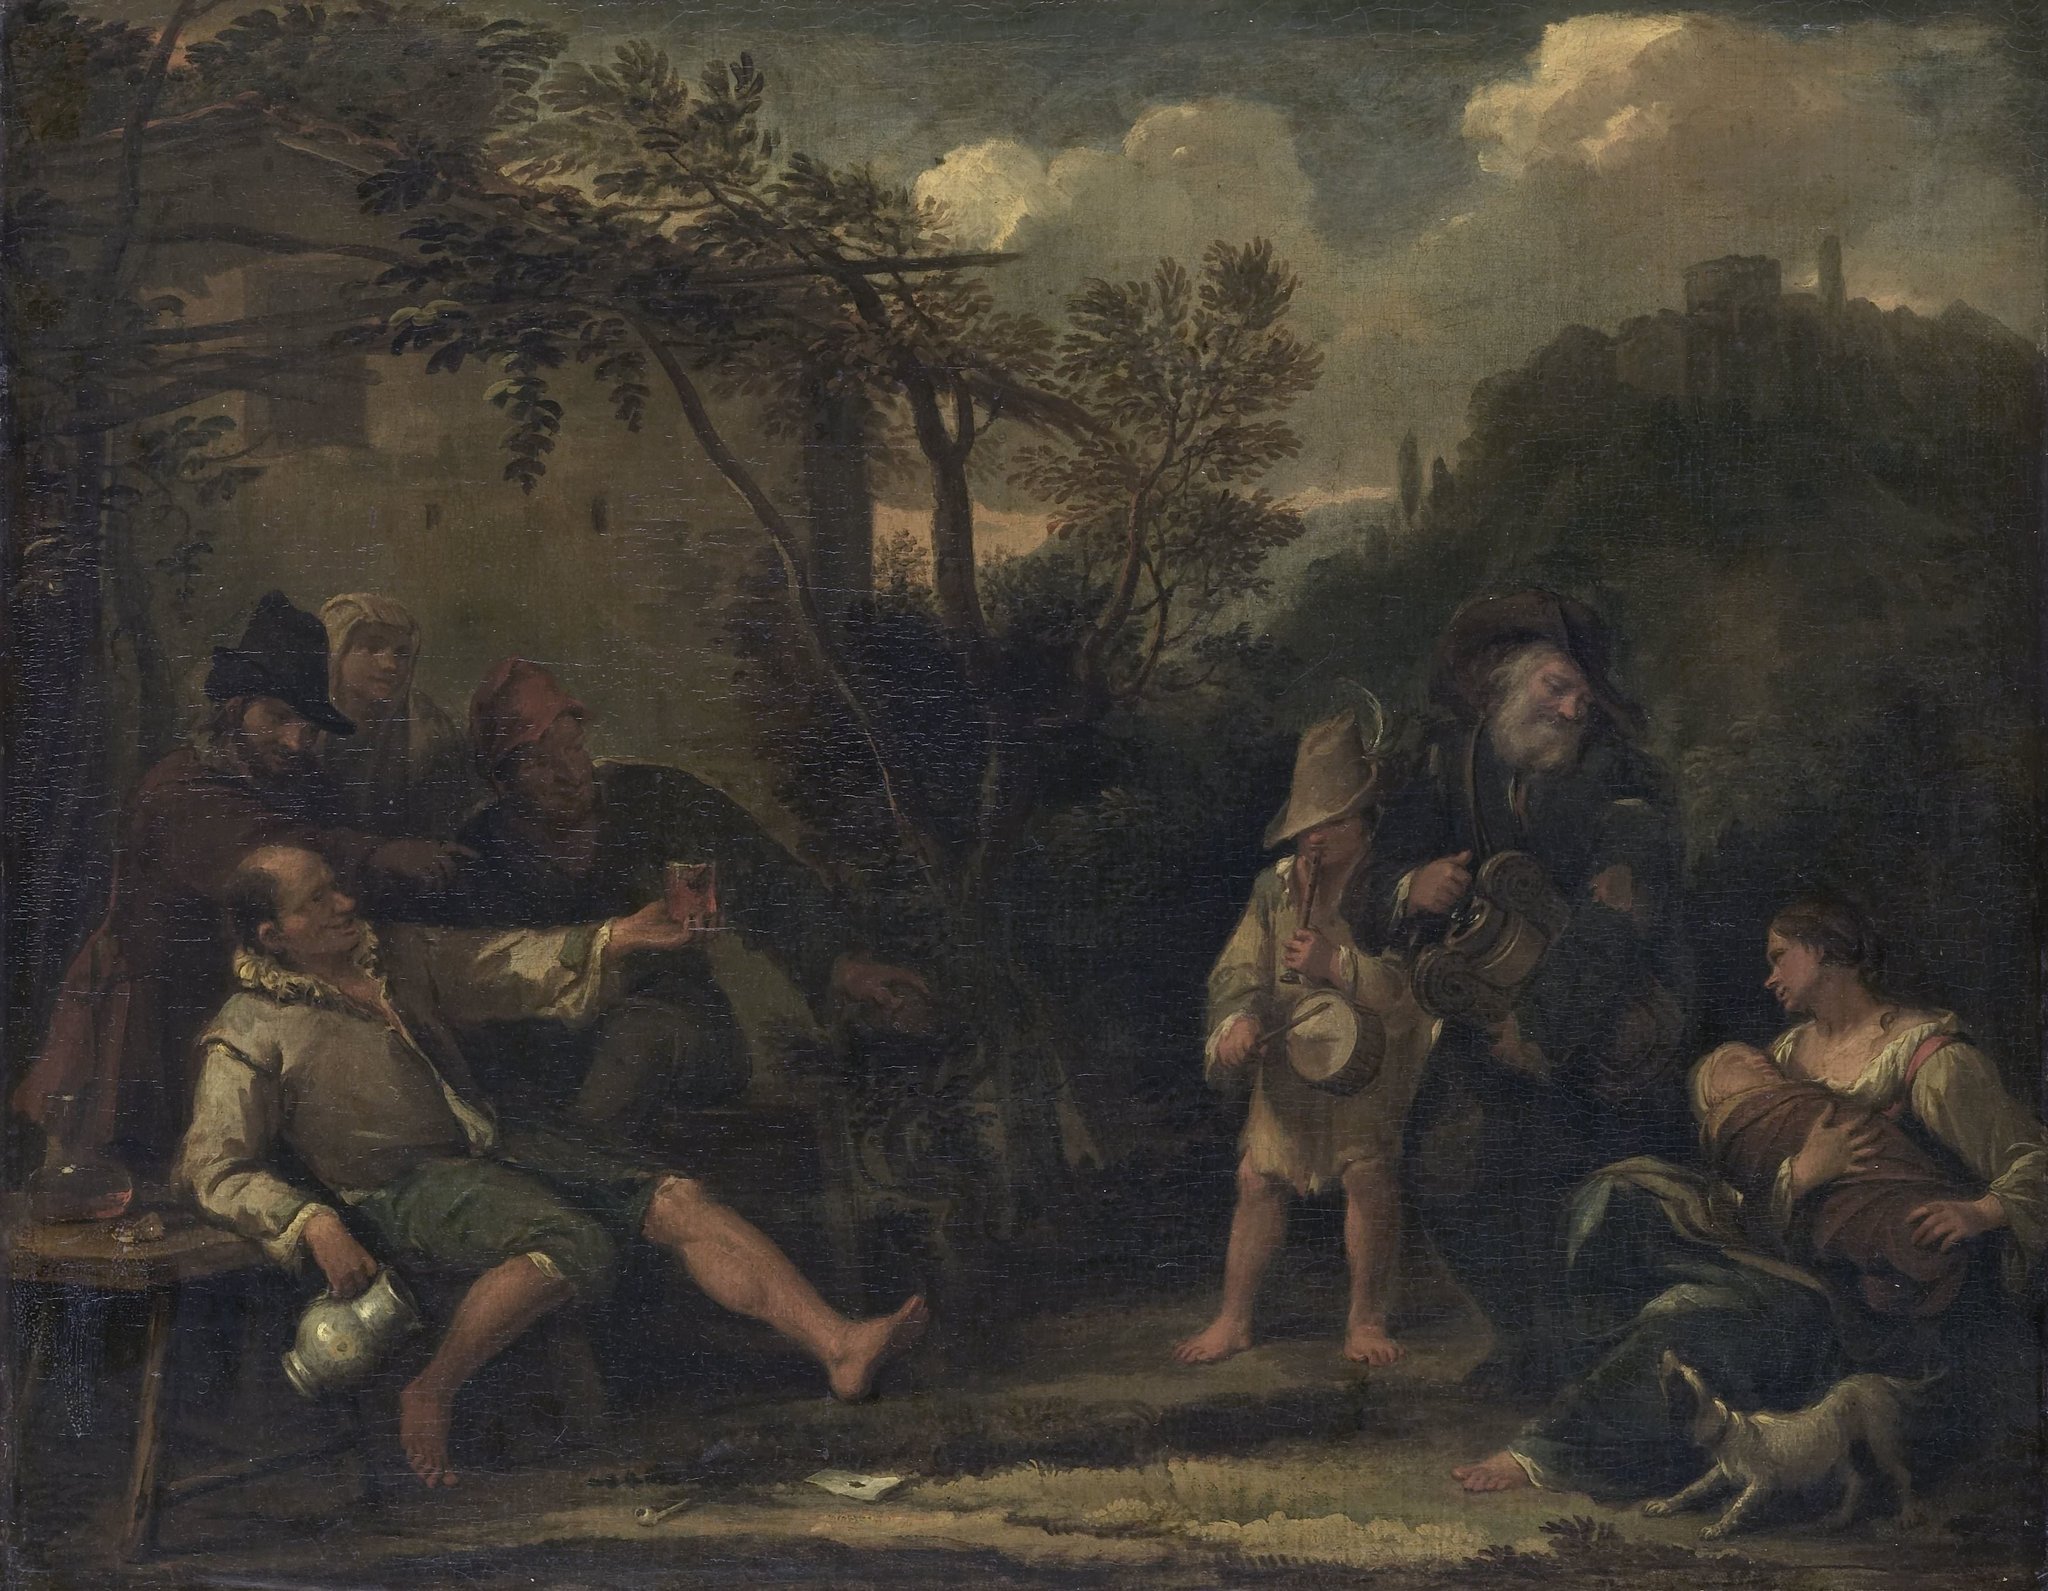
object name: painting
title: Merry Company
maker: dirck helmbreeker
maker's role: draughtsman, painter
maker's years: 1633-1696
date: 1675-1702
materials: canvas, oil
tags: pavement, terrace in front of inn or restaurant, popular music, street music, private festivities, merry company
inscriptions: signature (false): ‘J. Steen’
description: Vrolijk gezelschap buiten op het terras voor een herberg. Links mannen aan een tafel, één houdt een glas omhoog. In het midden speelt een oude man op een lier en een jongen op een fluit. Rechts een vrouw met een kind op schoot en een blaffende hond.